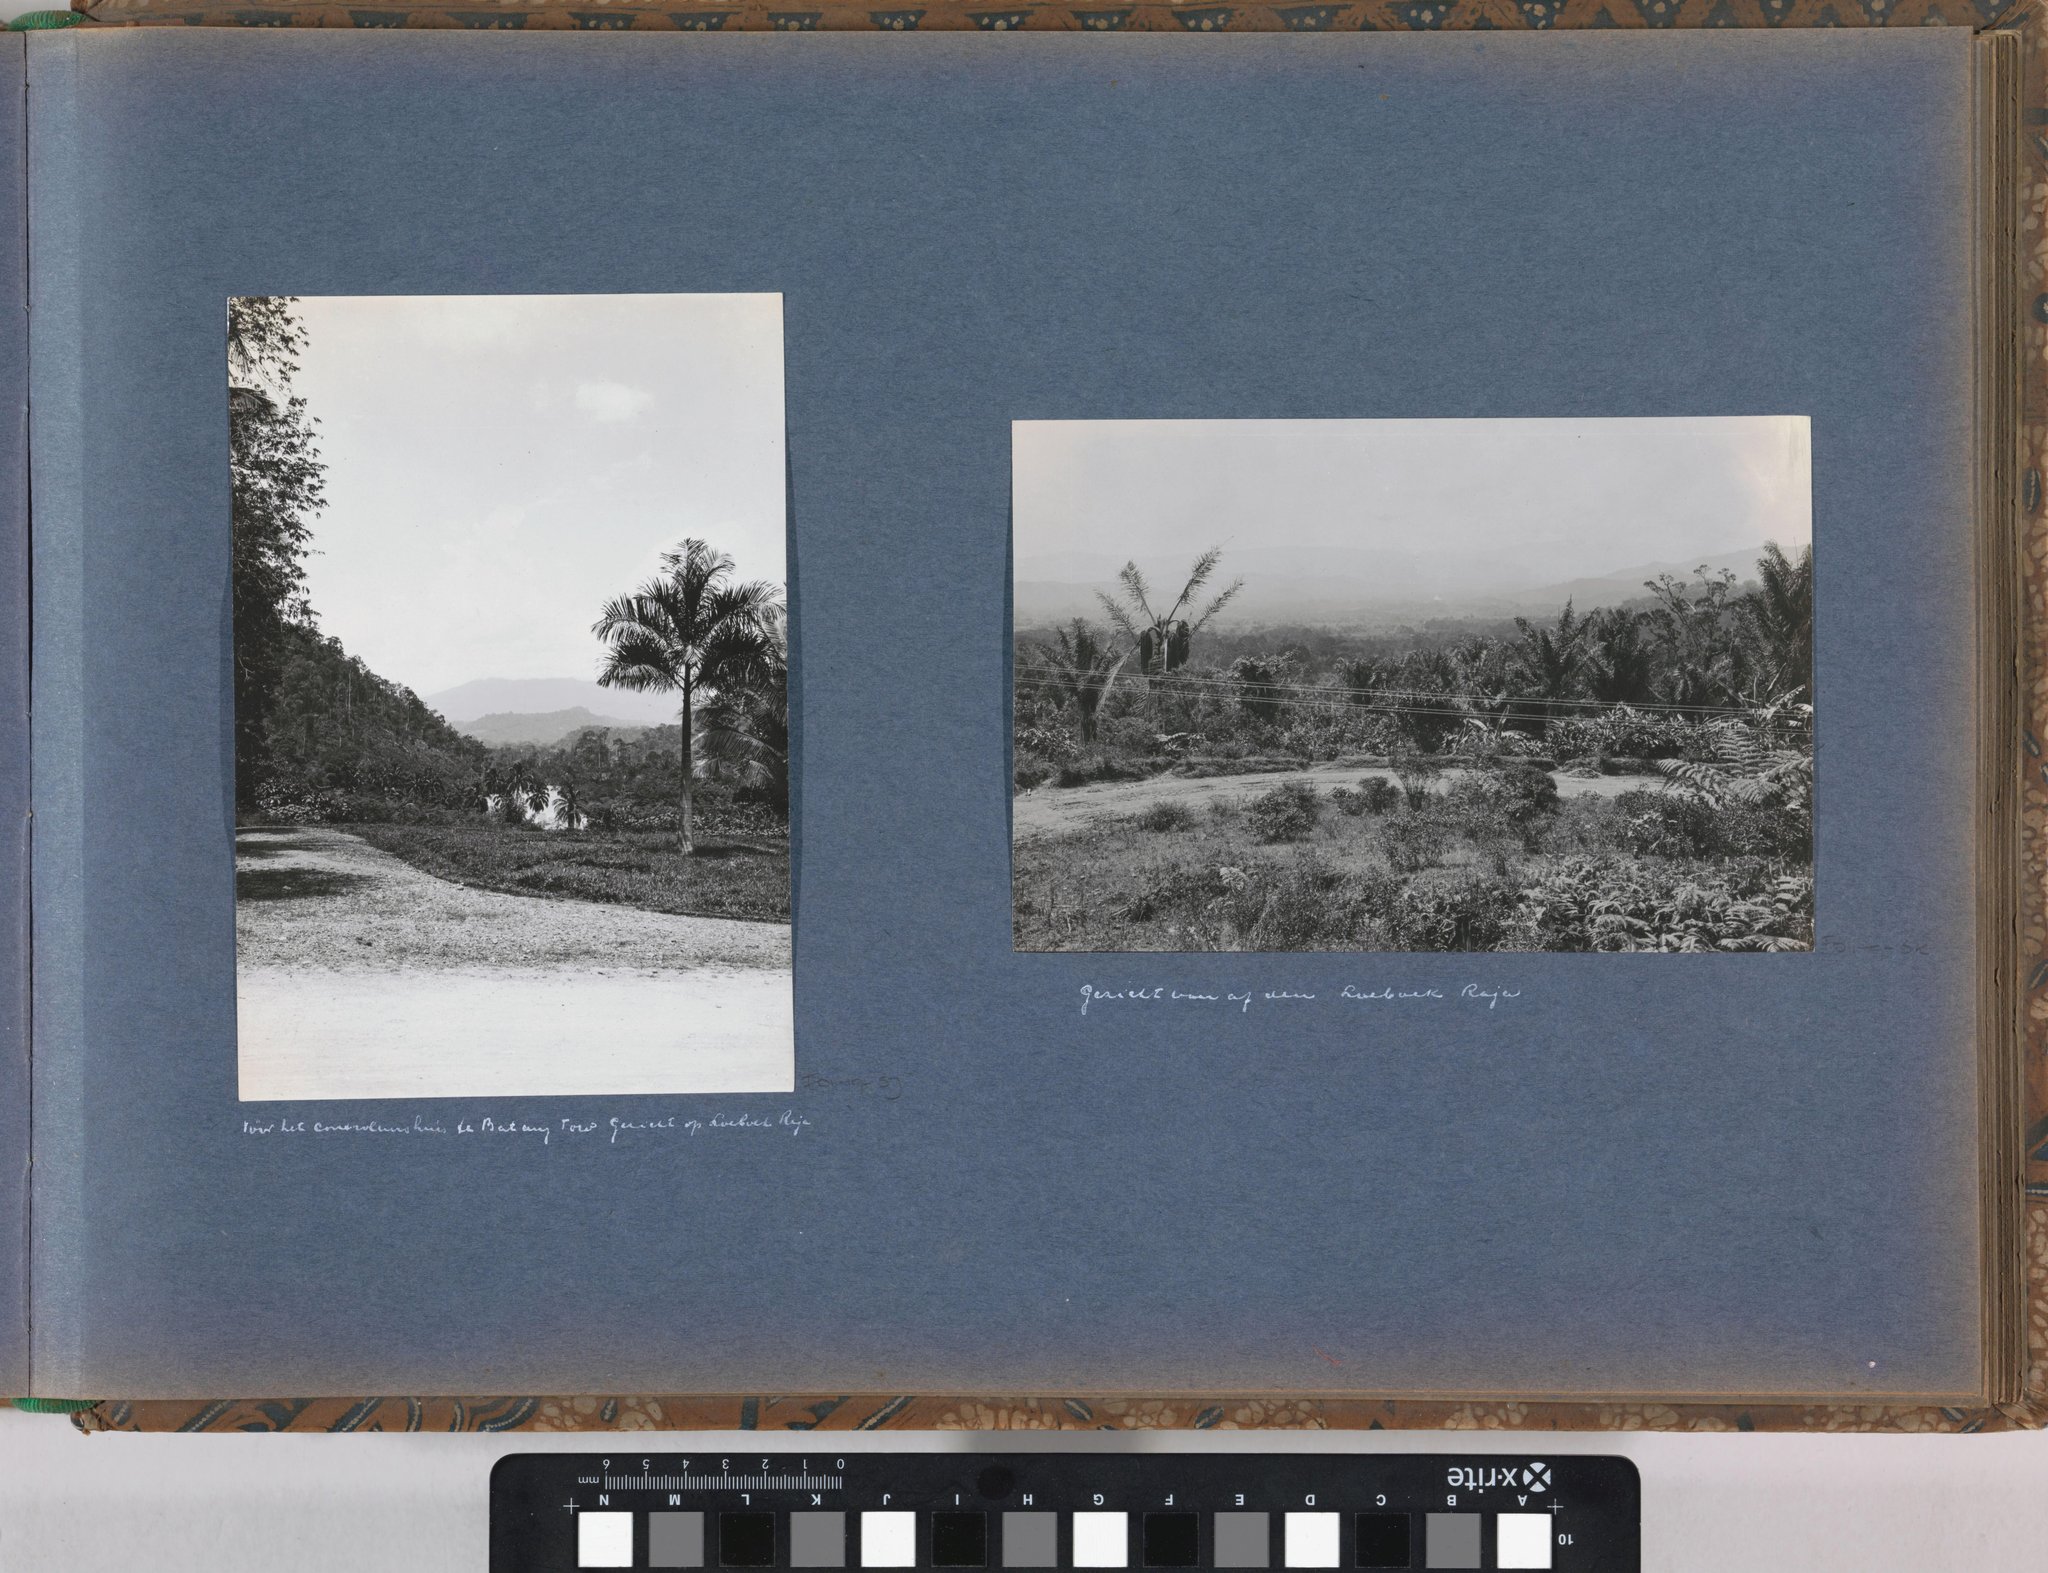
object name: album leaf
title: Landschap op Sumatra gezien vanaf Loeboek Rajah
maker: Anonymous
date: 1900-1920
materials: paper, photographic support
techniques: gelatin silver print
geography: sumatra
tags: landscapes in tropical and sub-tropical regions, sumatra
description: Onderdeel van reisalbum met foto's van bedrijvigheid en bezienswaardigheden op Sumatra en Java en van de reis naar en van Nederlands-Indië.